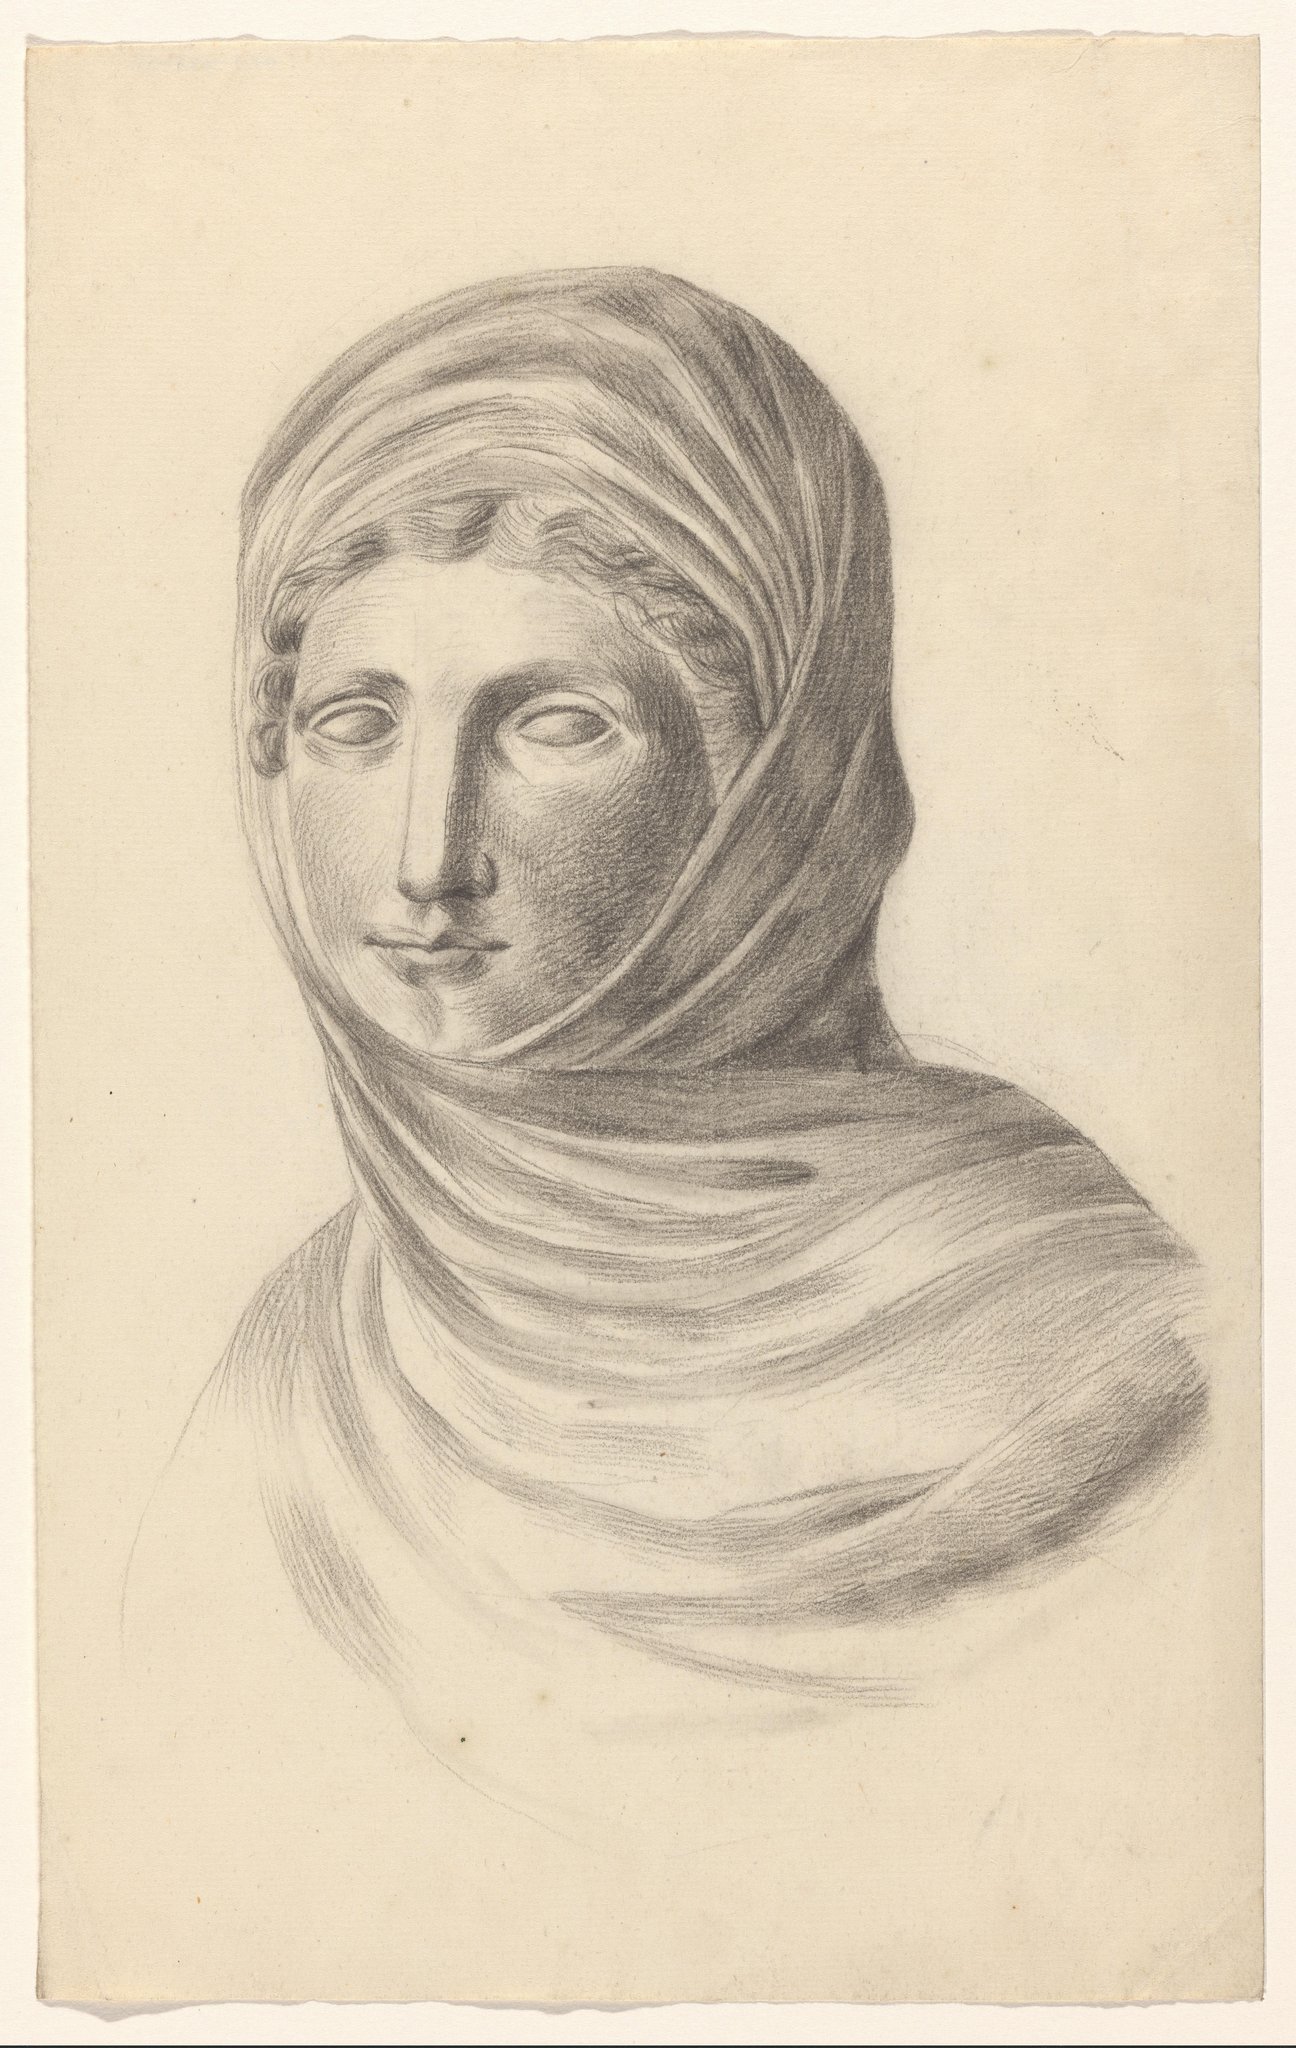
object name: drawing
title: Studie van buste van een vrouw met hoofddoek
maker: Anonymous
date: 1830-1880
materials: chalk, paper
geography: netherlands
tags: head-gear, sculpture, classical antiquity (historical epoch)